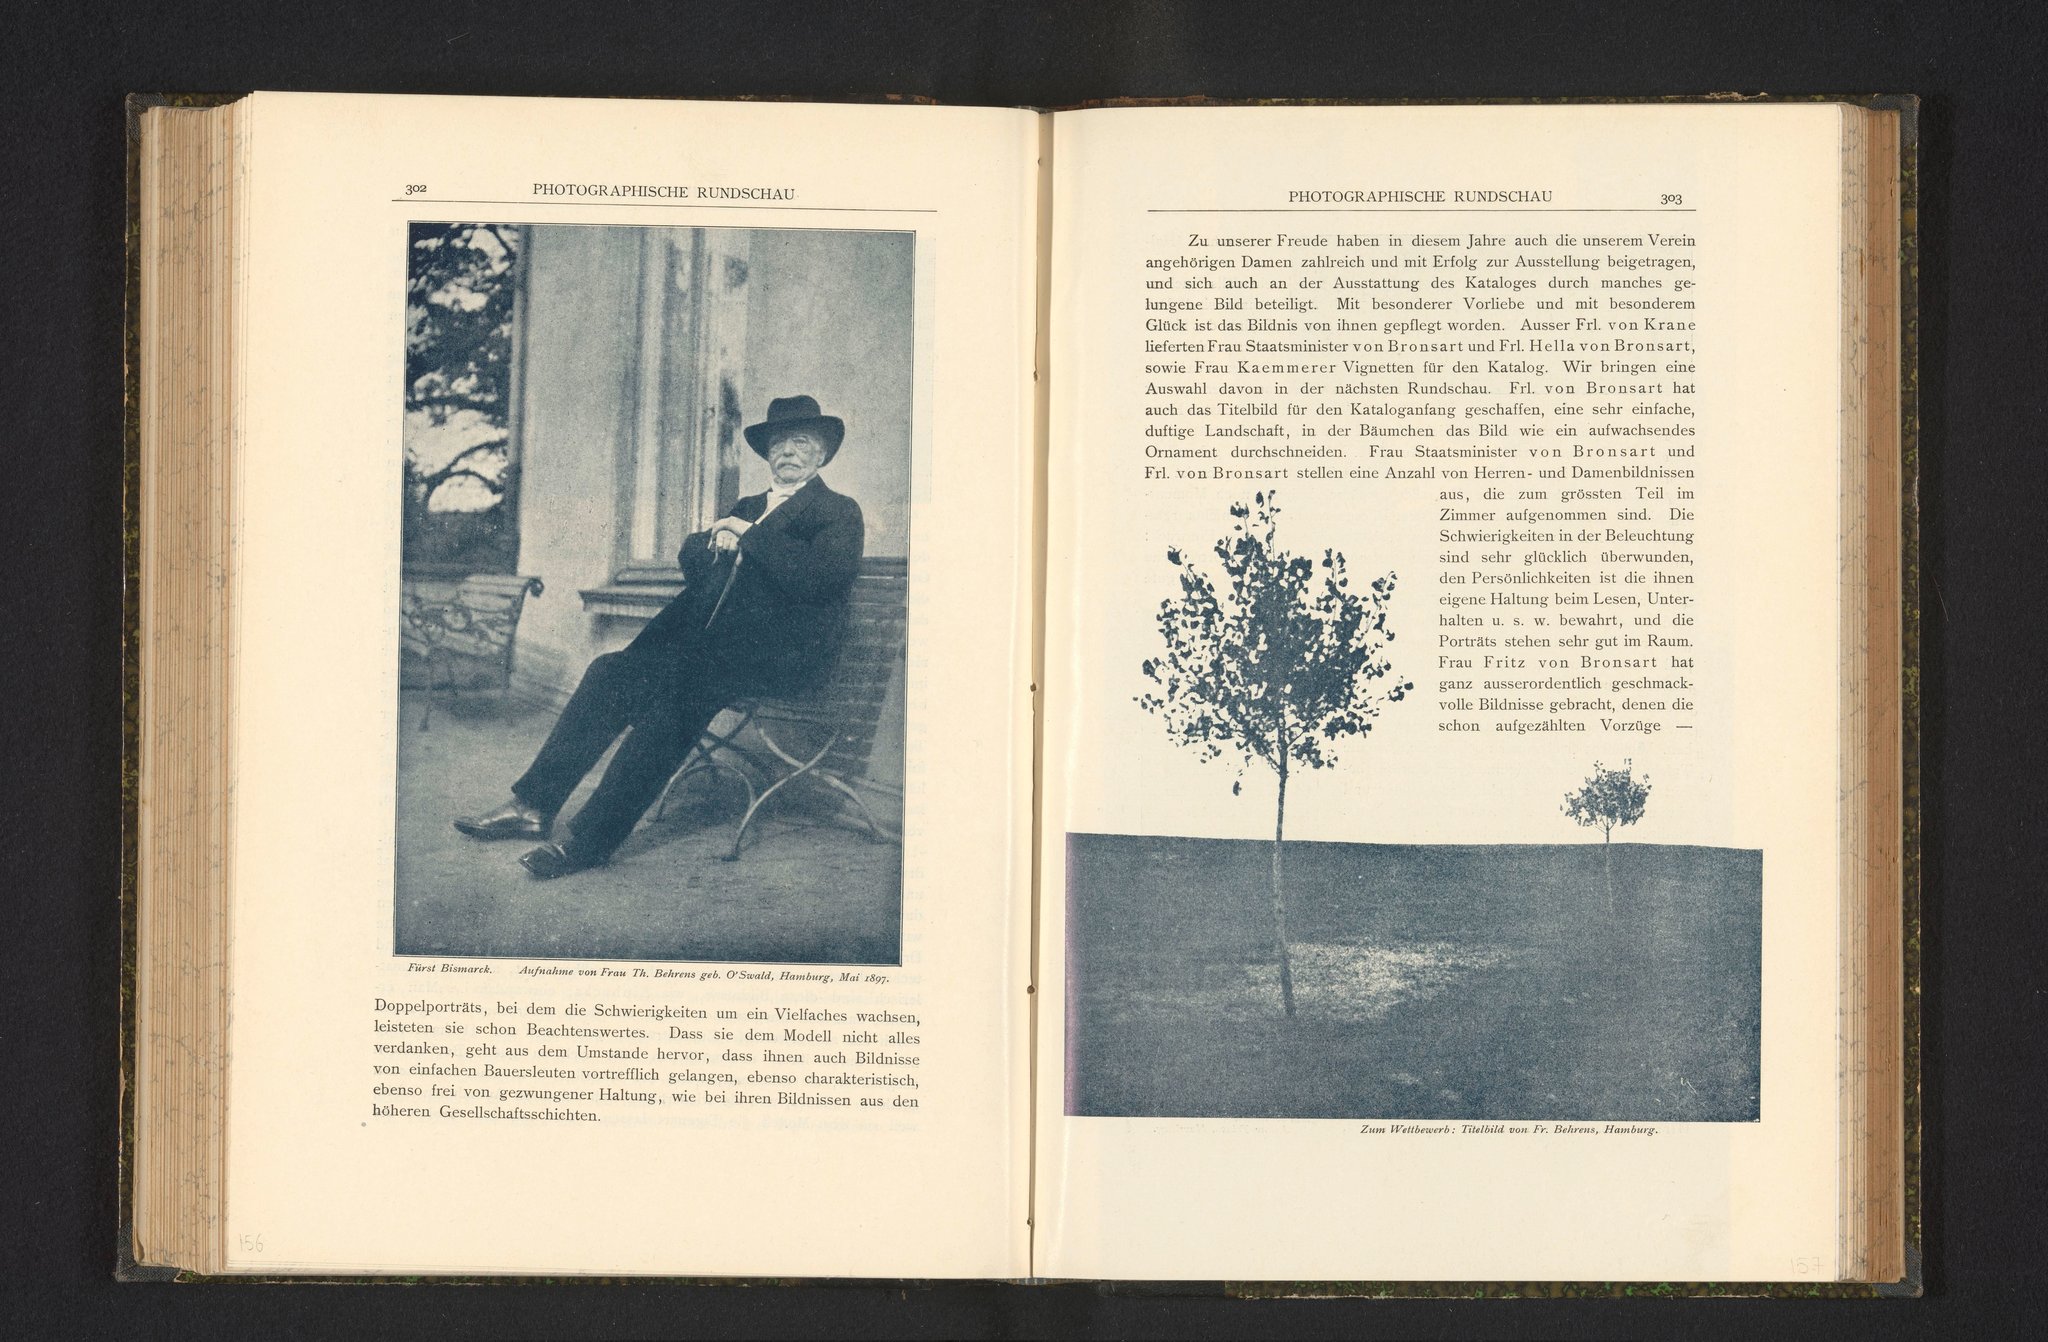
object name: page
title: Zum Wettbewerb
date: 1893-1898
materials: paper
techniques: autotype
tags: trees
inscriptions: inscription: ‘Titelbild von Fr. Behrens, Hamburg.’